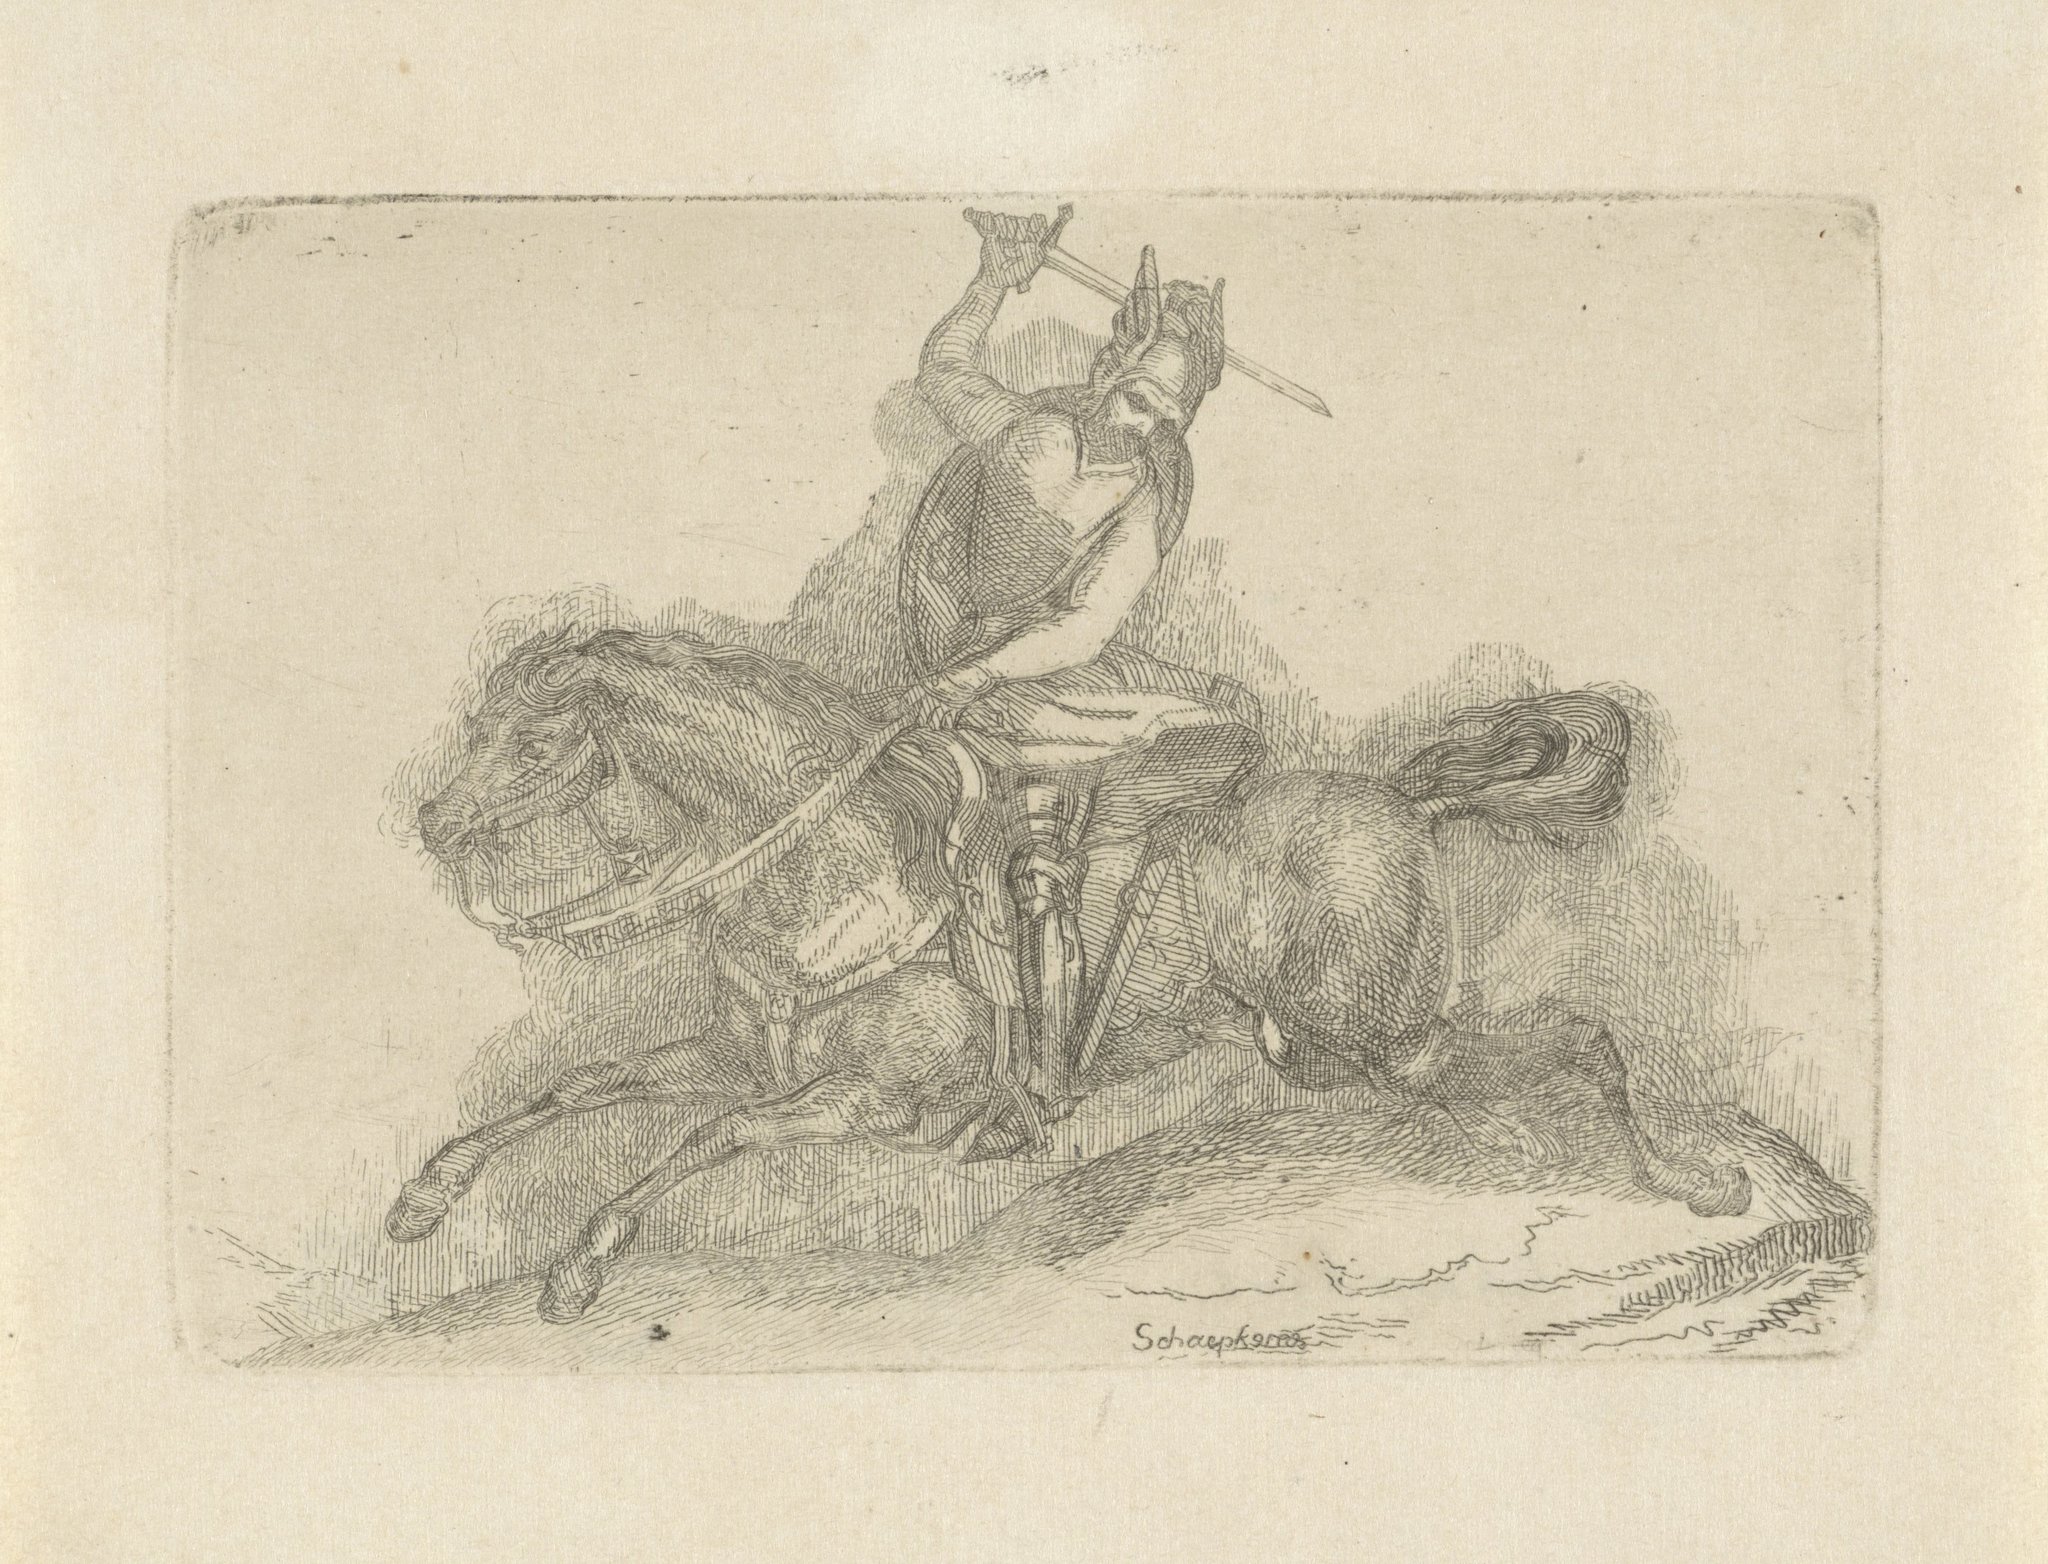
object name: print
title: Ruiter te paard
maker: arnoud schaepkens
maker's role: print maker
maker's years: 1816-1904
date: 1831-1904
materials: paper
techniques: etching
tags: riding a horse, ass, or mule; rider, horseman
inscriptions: collector's mark: Lugt 2228